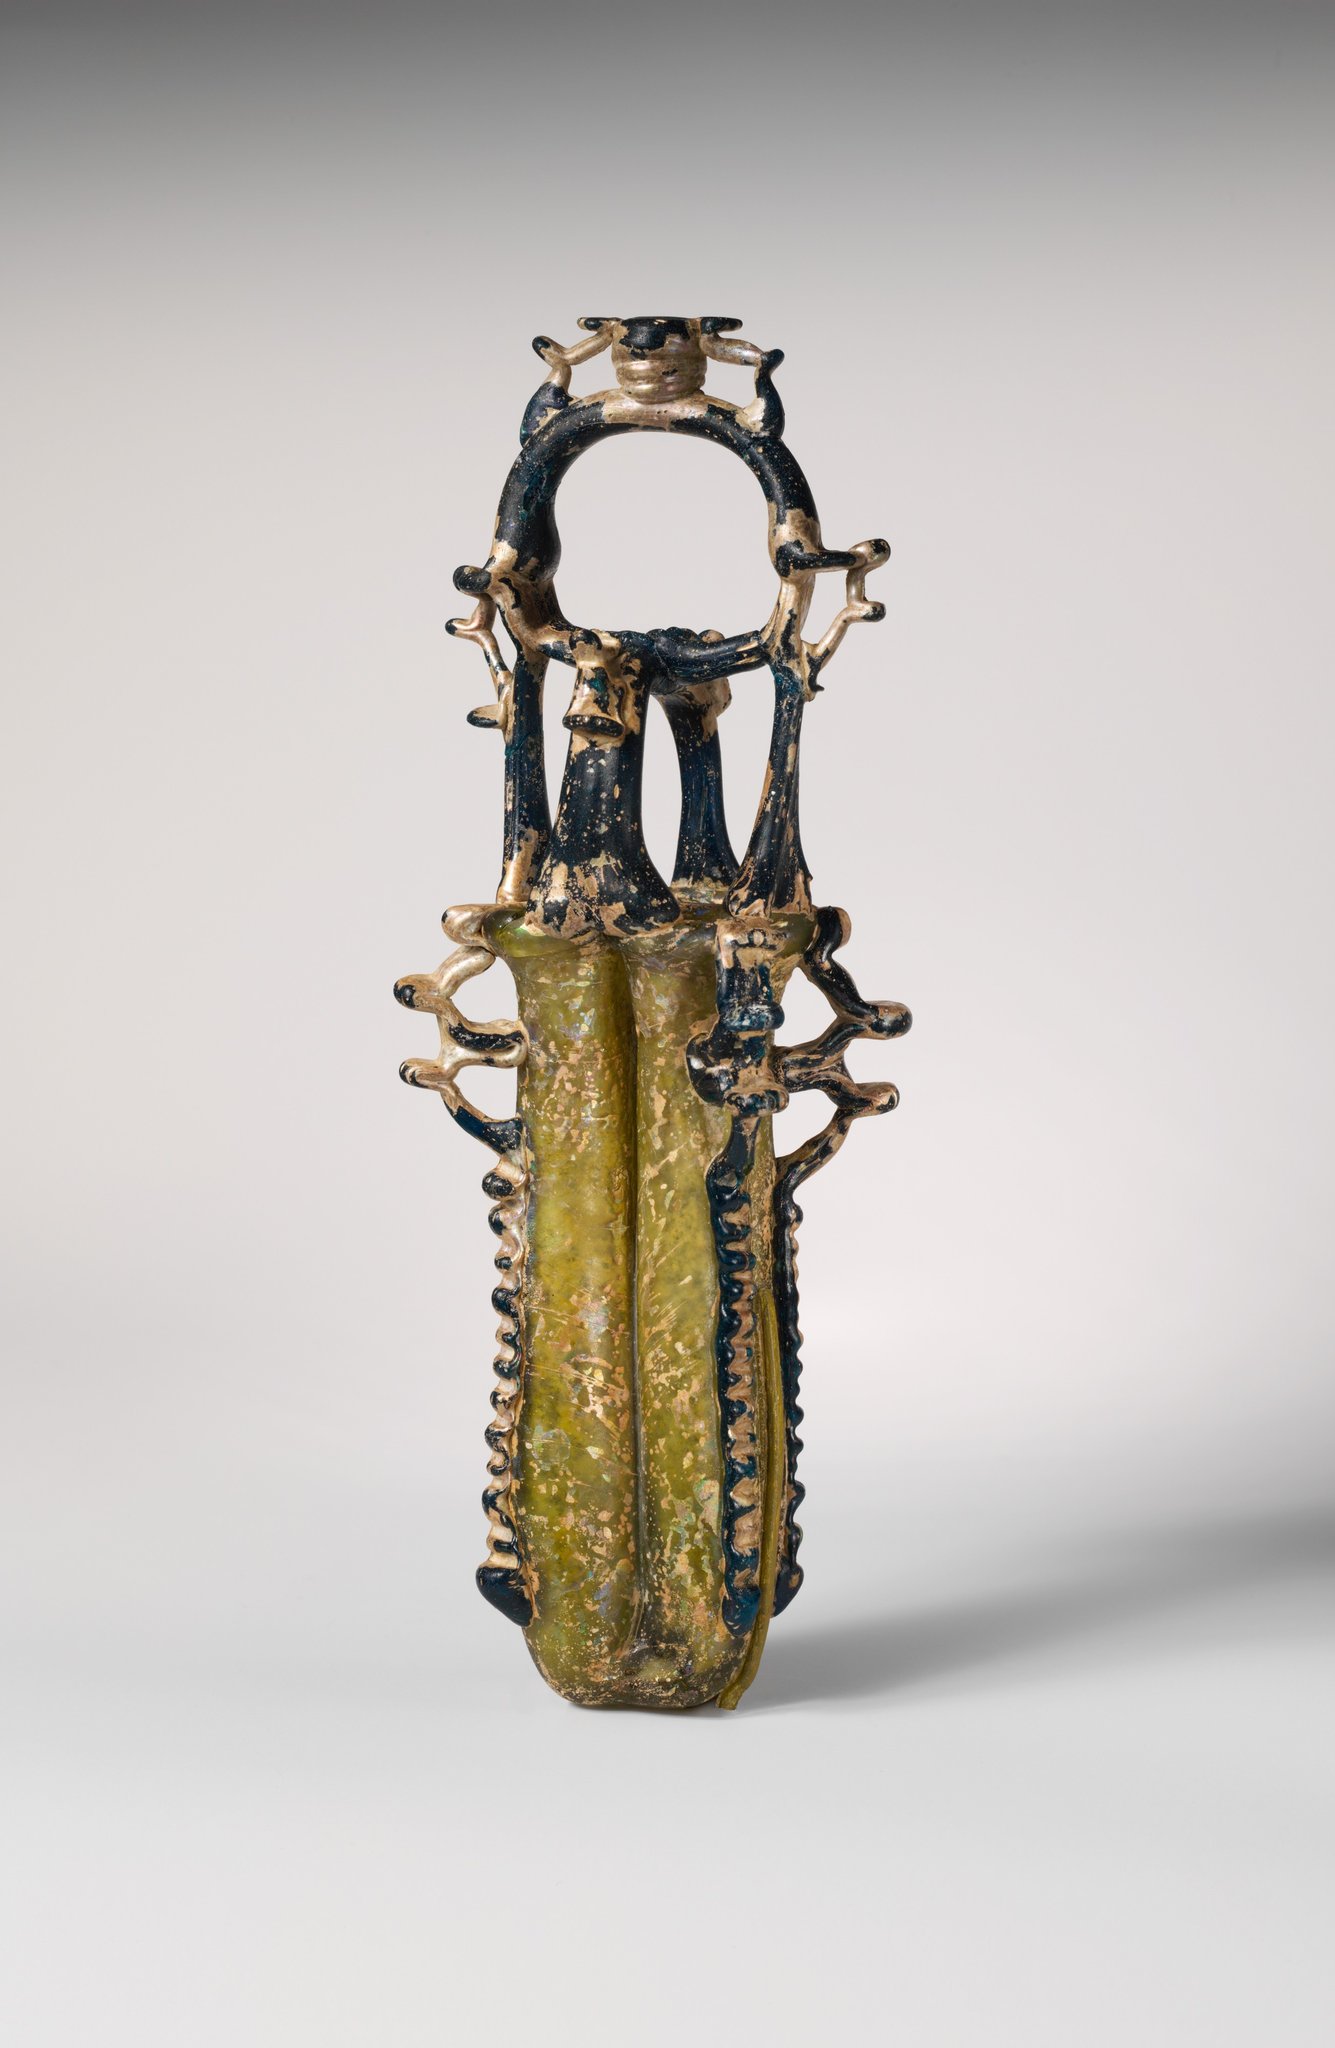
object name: cosmetic flask, single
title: Glass multiple cosmetic flask (kohl tube)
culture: roman, syrian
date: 401-500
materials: glass